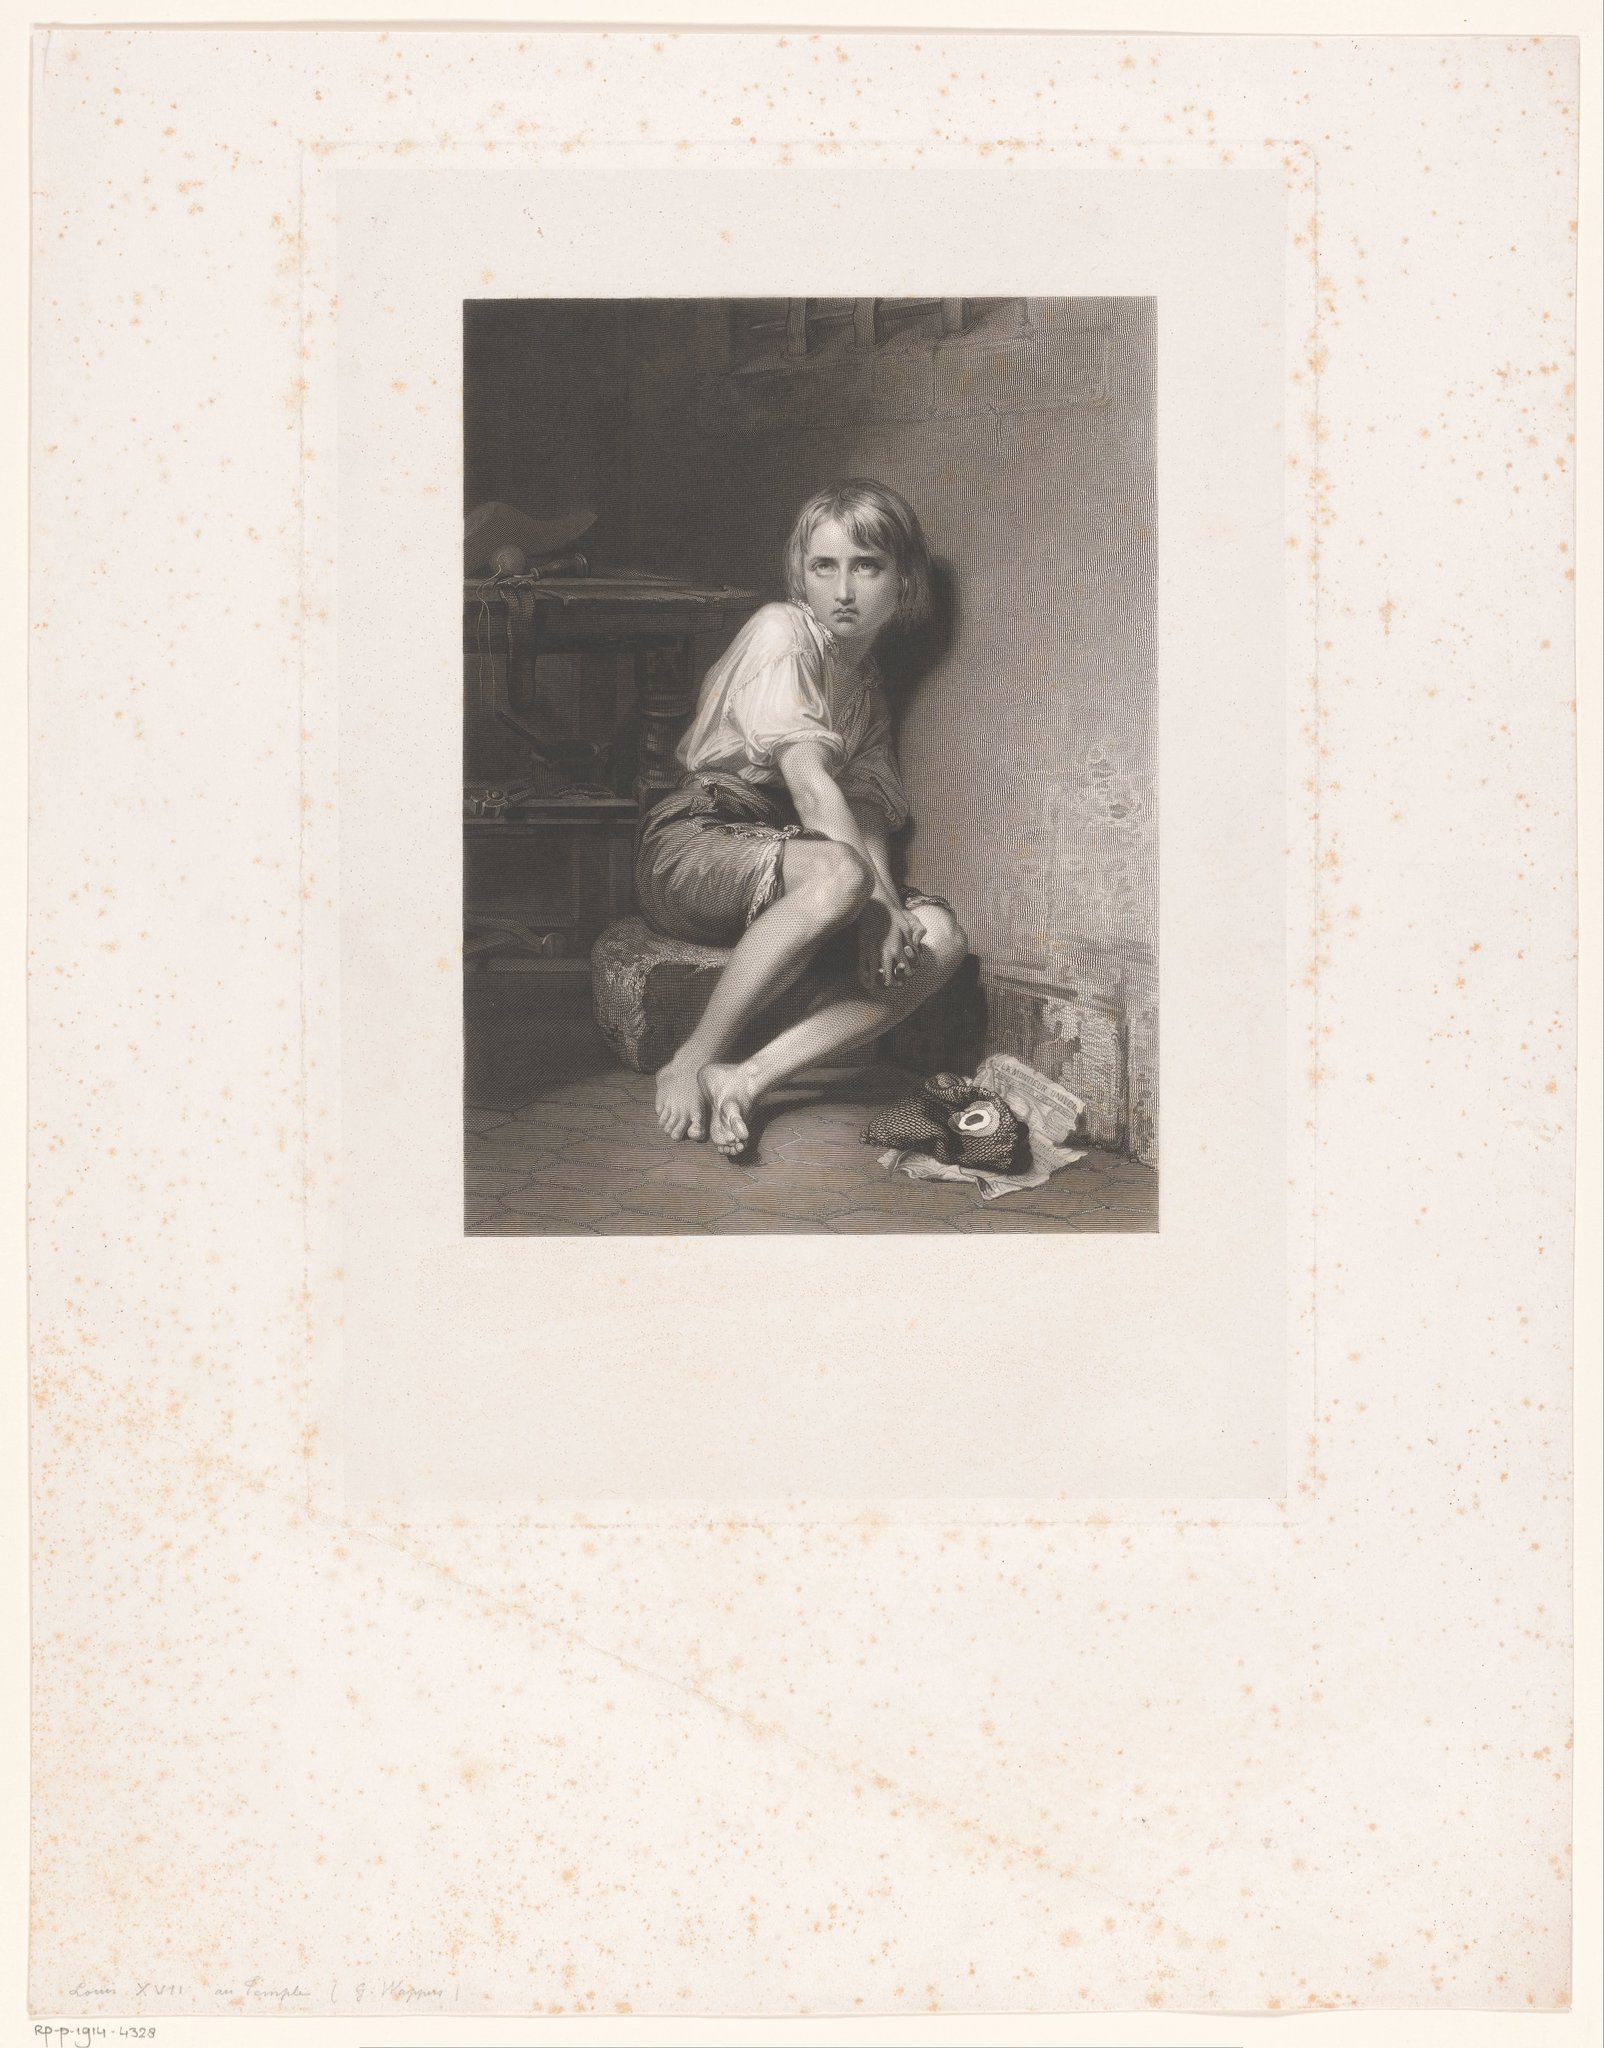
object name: print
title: Lodewijk XVII in de tempel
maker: françois de meersman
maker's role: print maker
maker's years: 1830-1905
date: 1850-1905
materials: paper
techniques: engraving, etching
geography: belgium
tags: boy (child between toddler and youth), head-gear: cap, beggar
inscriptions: collector's mark: Lugt 2228